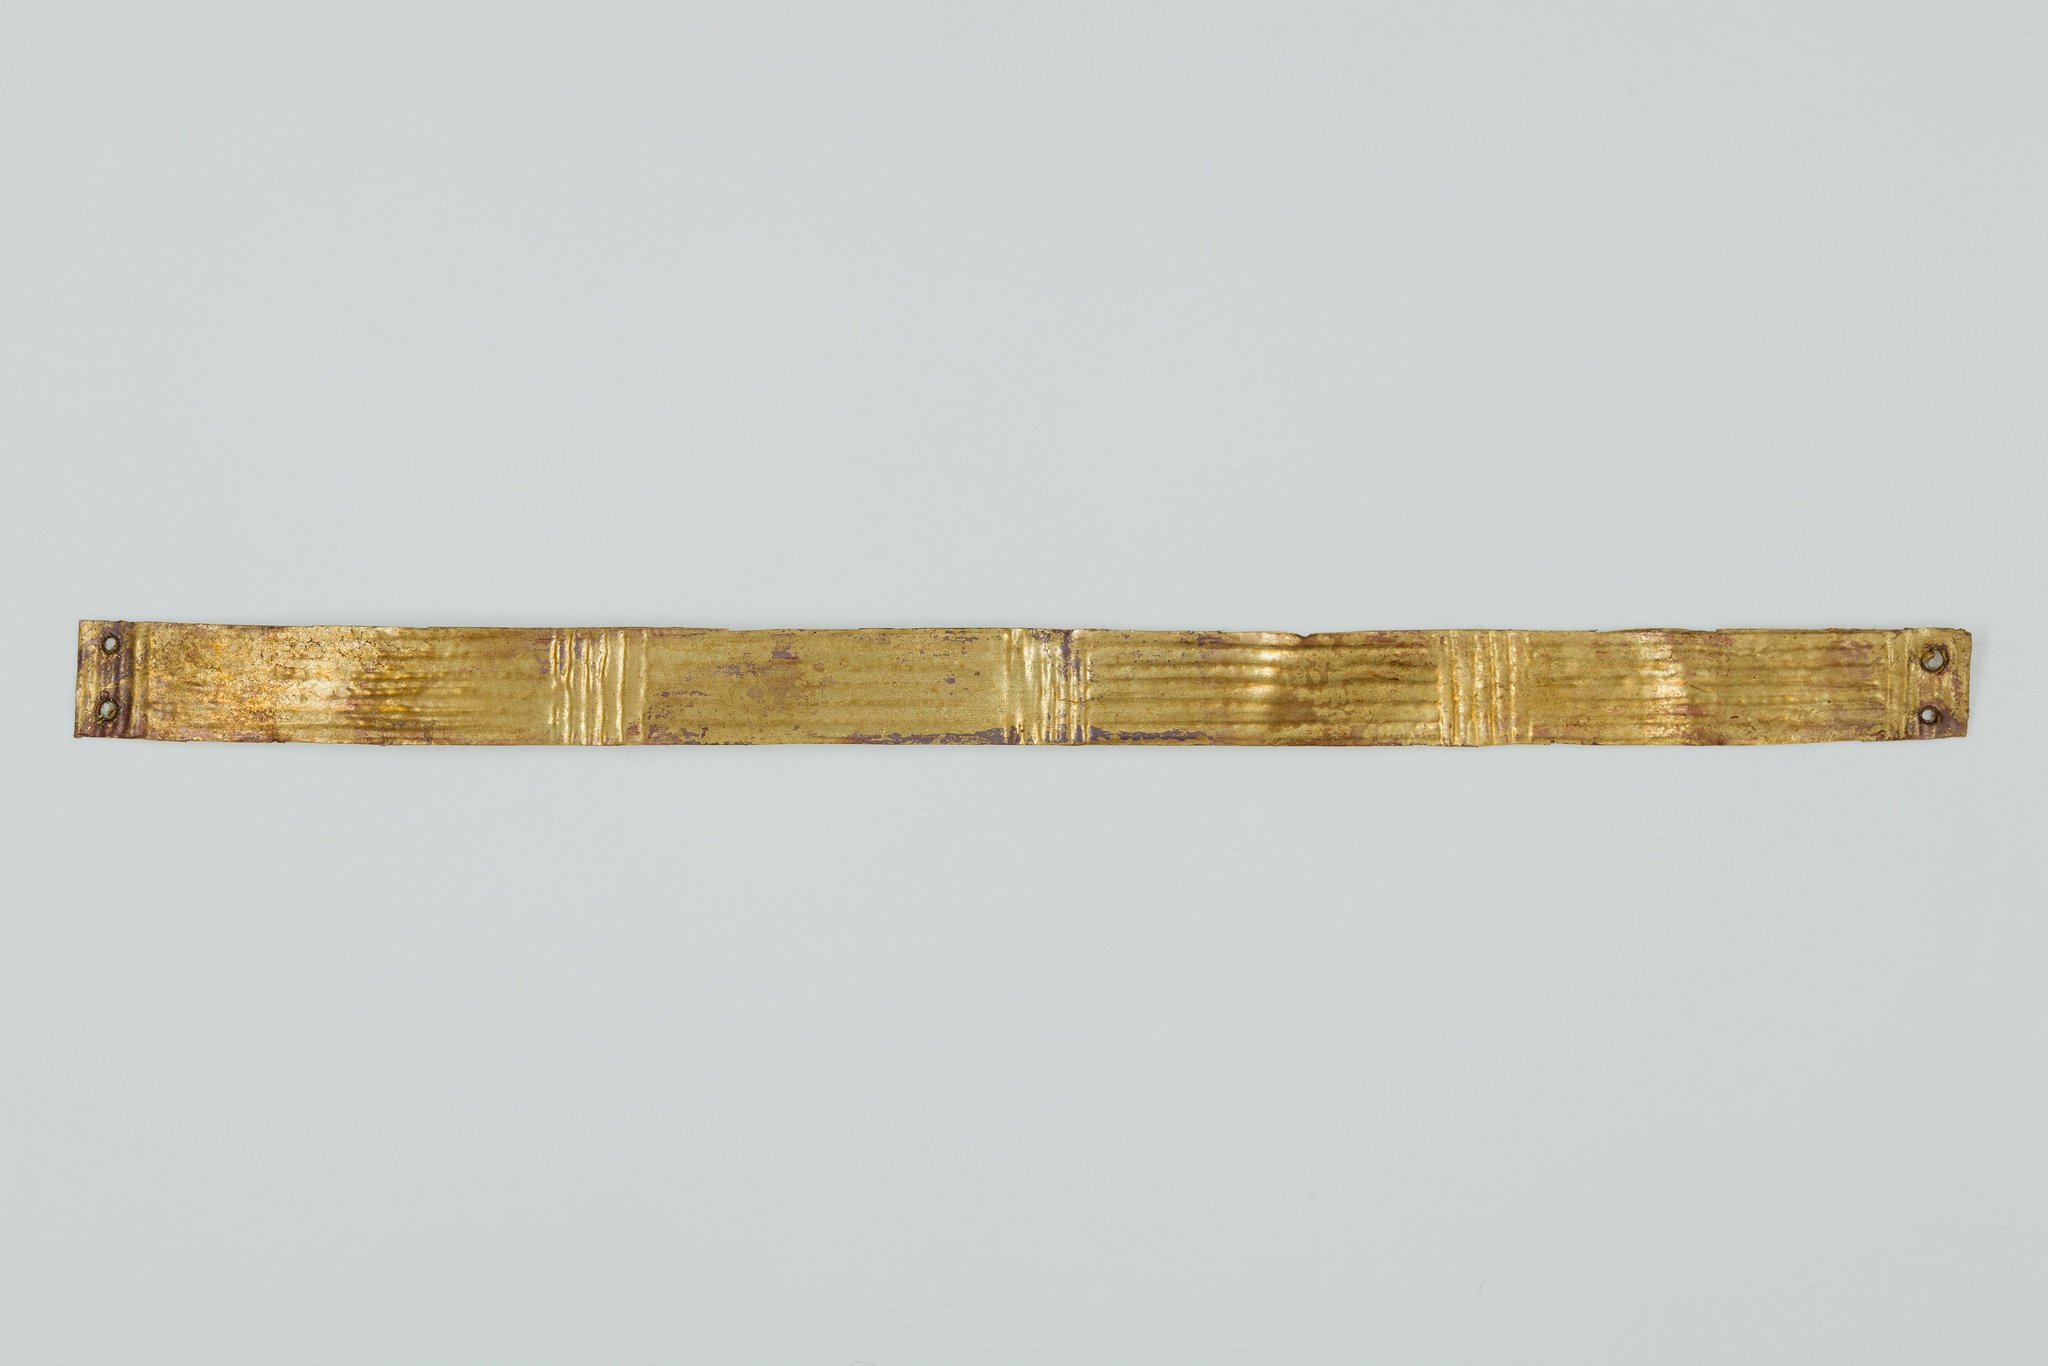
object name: amulet, sheet gold, bracelet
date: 664-380 BCE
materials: gold